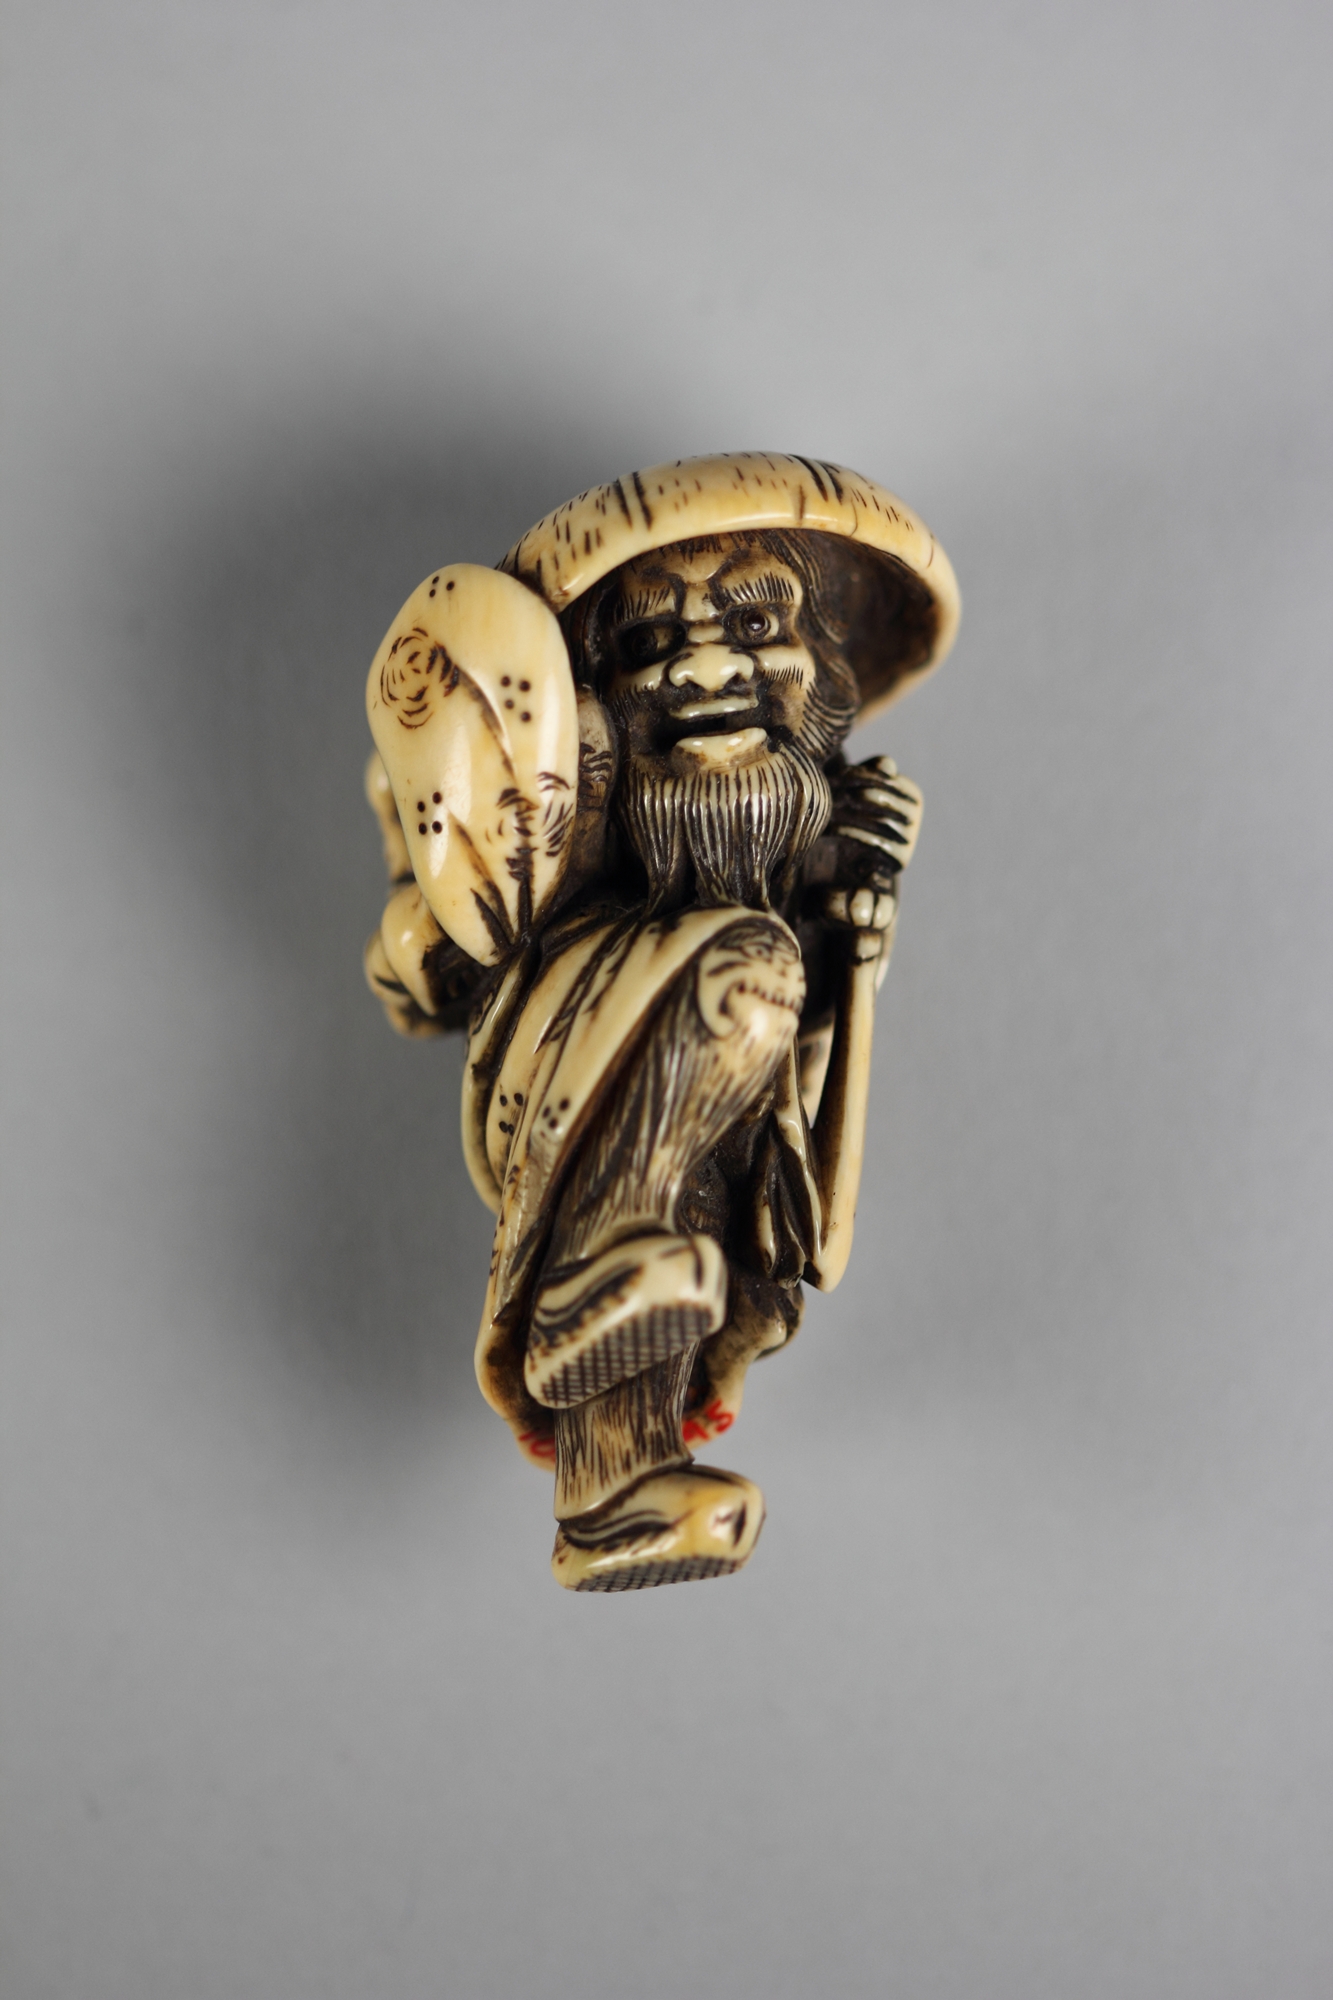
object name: netsuke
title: Shōki the Demon Queller and a Small Demon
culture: japanese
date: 1701-1800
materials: ivory